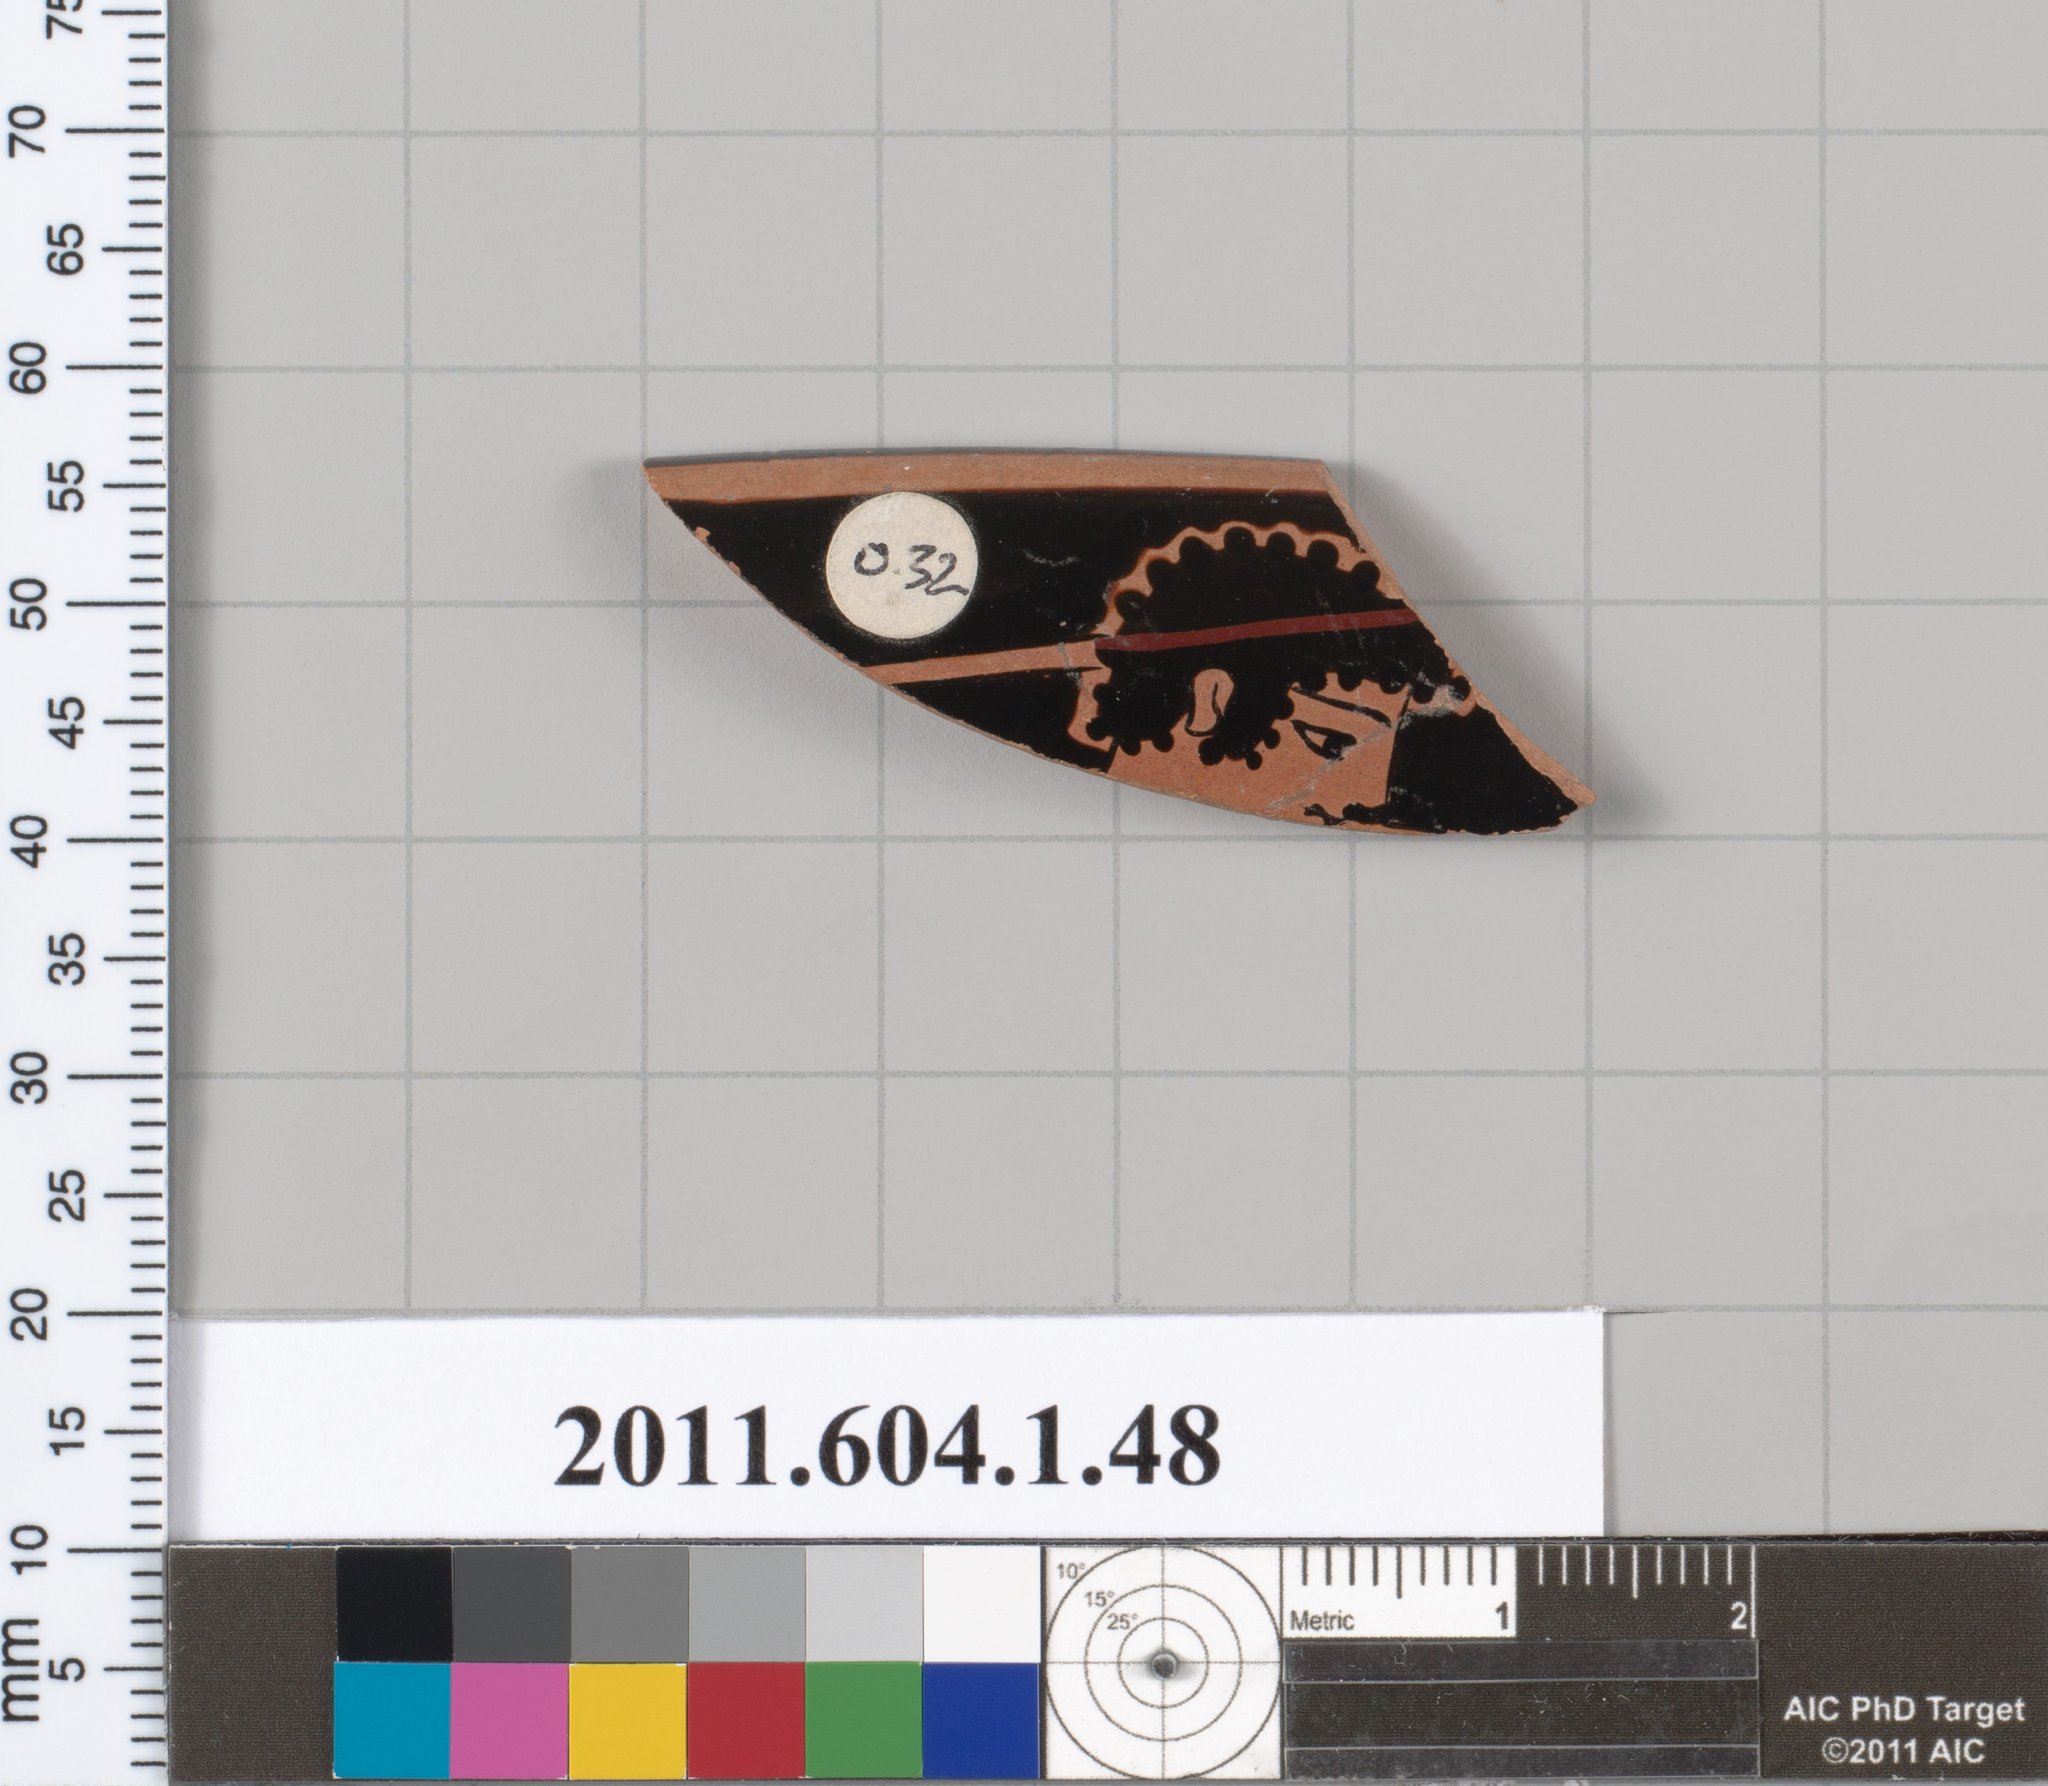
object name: kylix fragment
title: Terracotta rim fragment of a kylix (drinking cup)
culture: greek, attic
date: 490-480 BCE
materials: terracotta